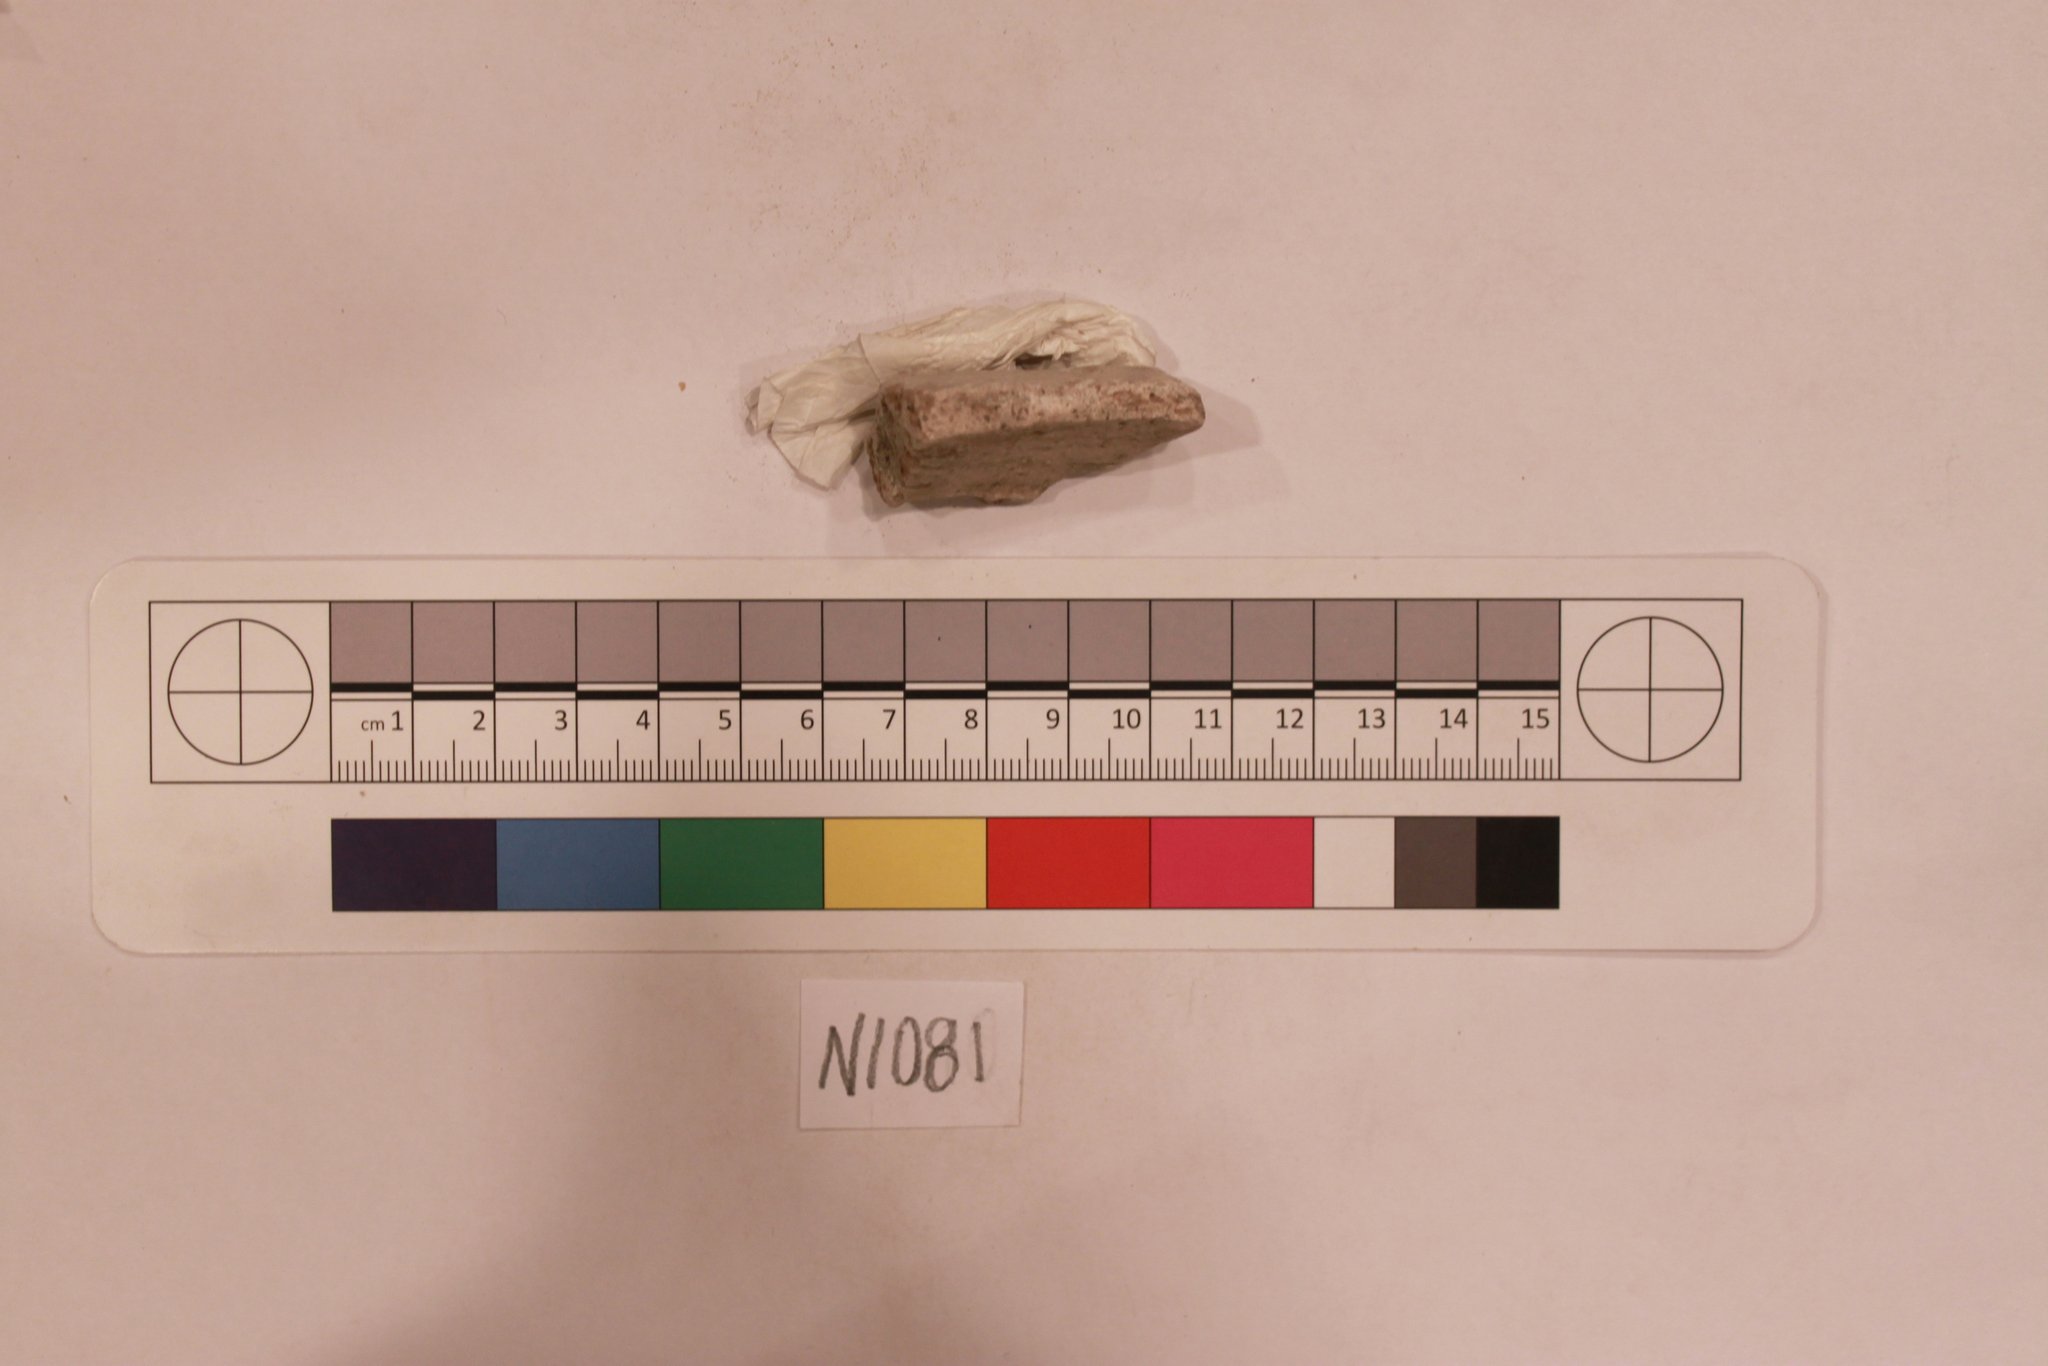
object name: fragment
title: Stucco Fragment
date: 701-1200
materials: plaster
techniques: carving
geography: iran